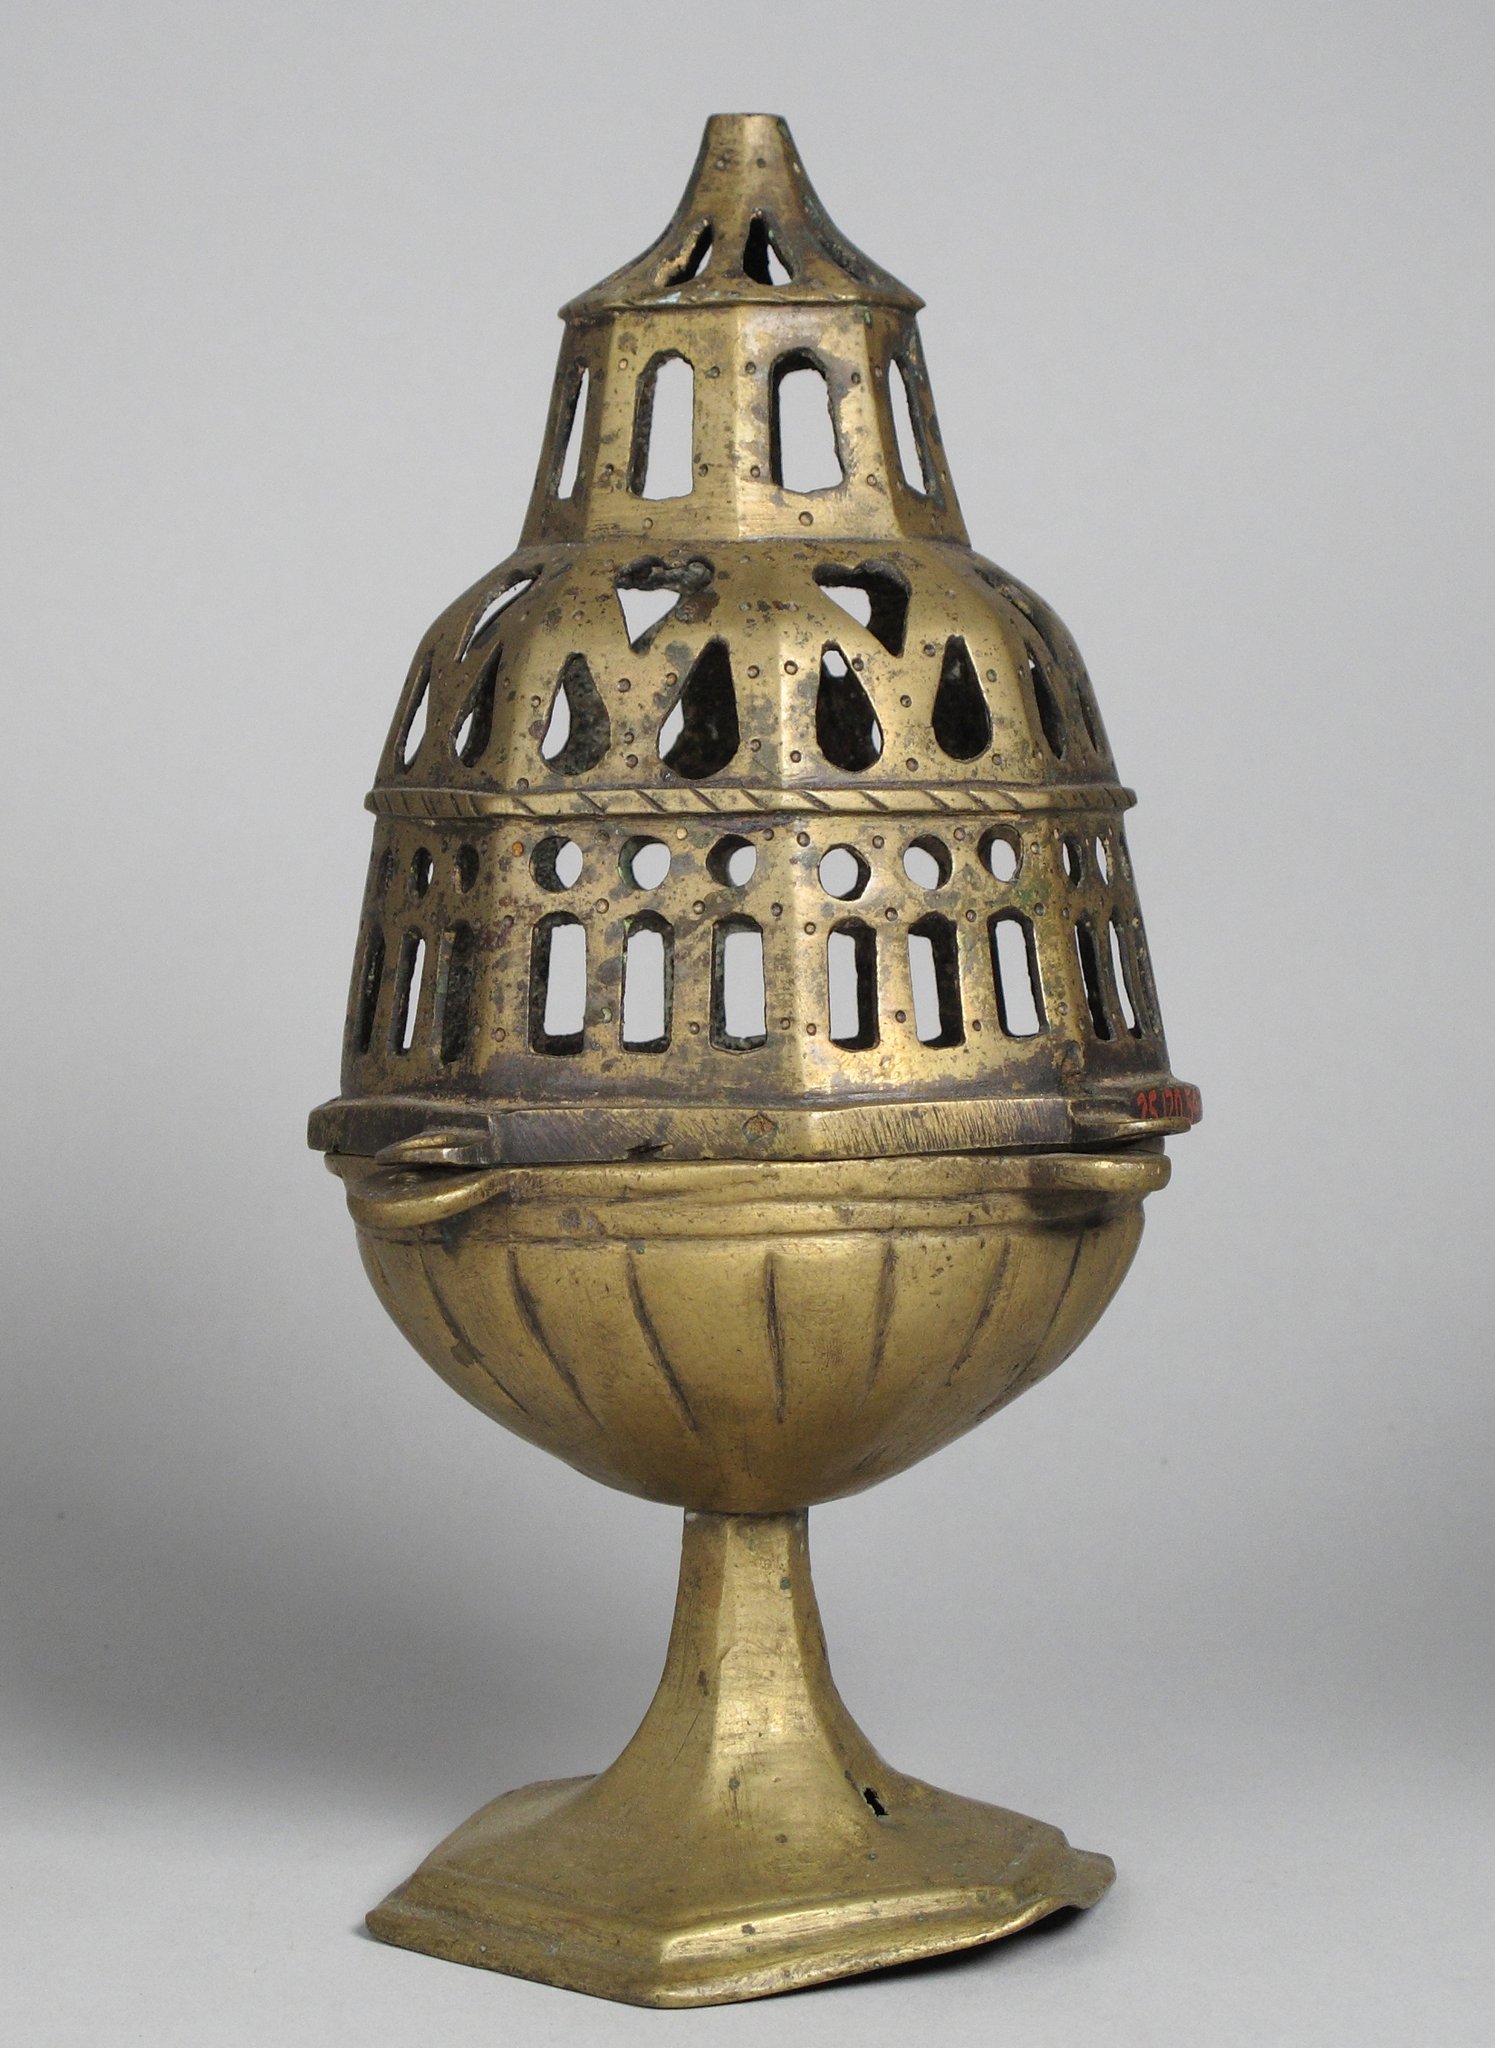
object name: censer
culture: french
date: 1501-1600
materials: copper alloy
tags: censers